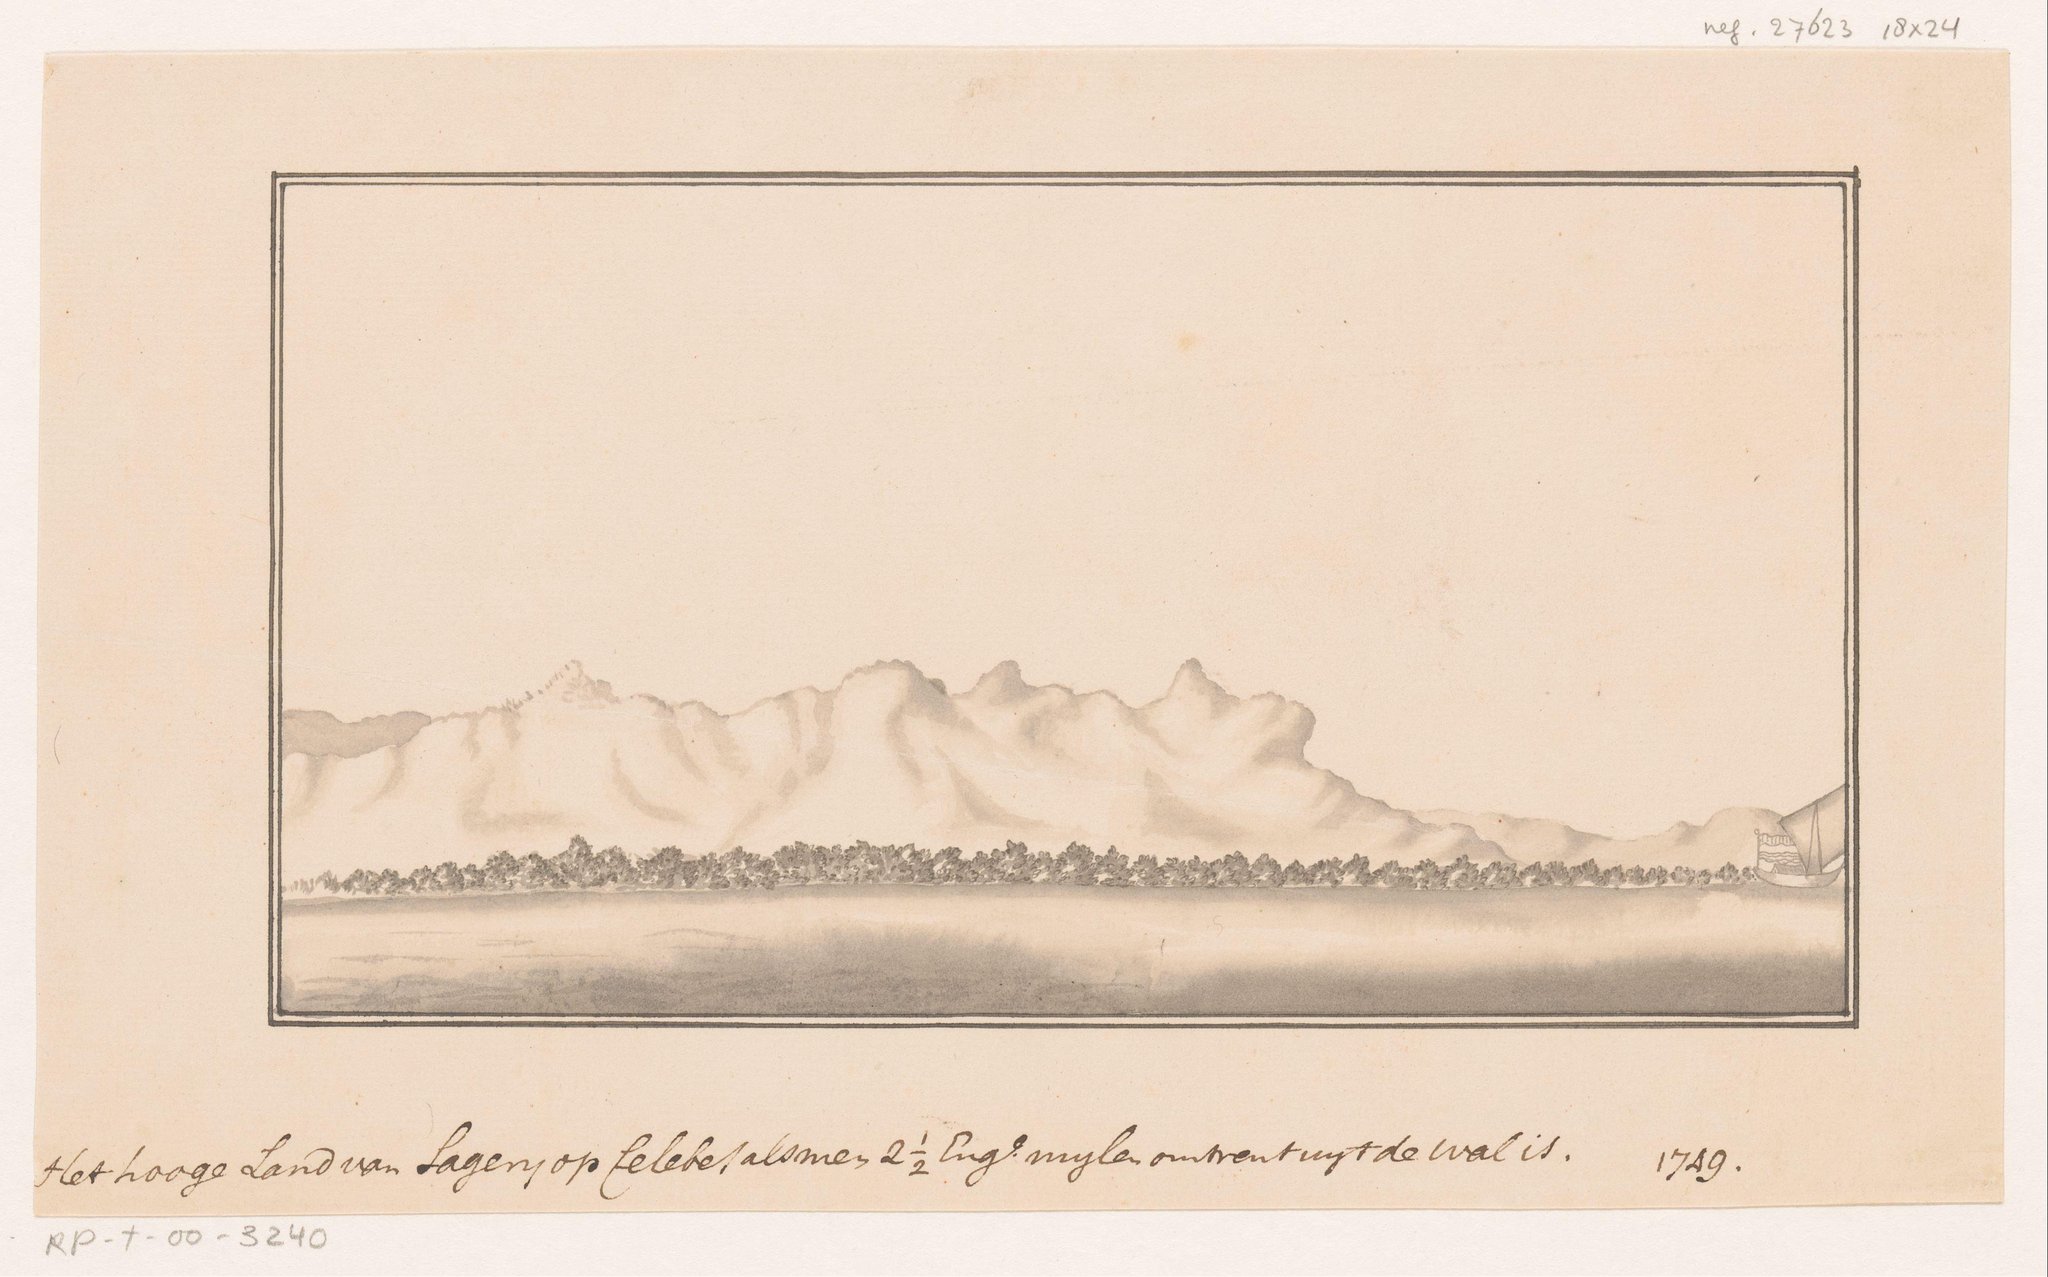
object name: drawing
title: Het hooge land van Sagen, op Celebes, alsmen 2 1/2 Eng[els]e mijlen omtrent uyt de wal is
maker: Anonymous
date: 1749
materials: ink, paper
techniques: brush, pen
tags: coast (in tropical and sub-tropical regions)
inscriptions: collector's mark: Lugt 2228